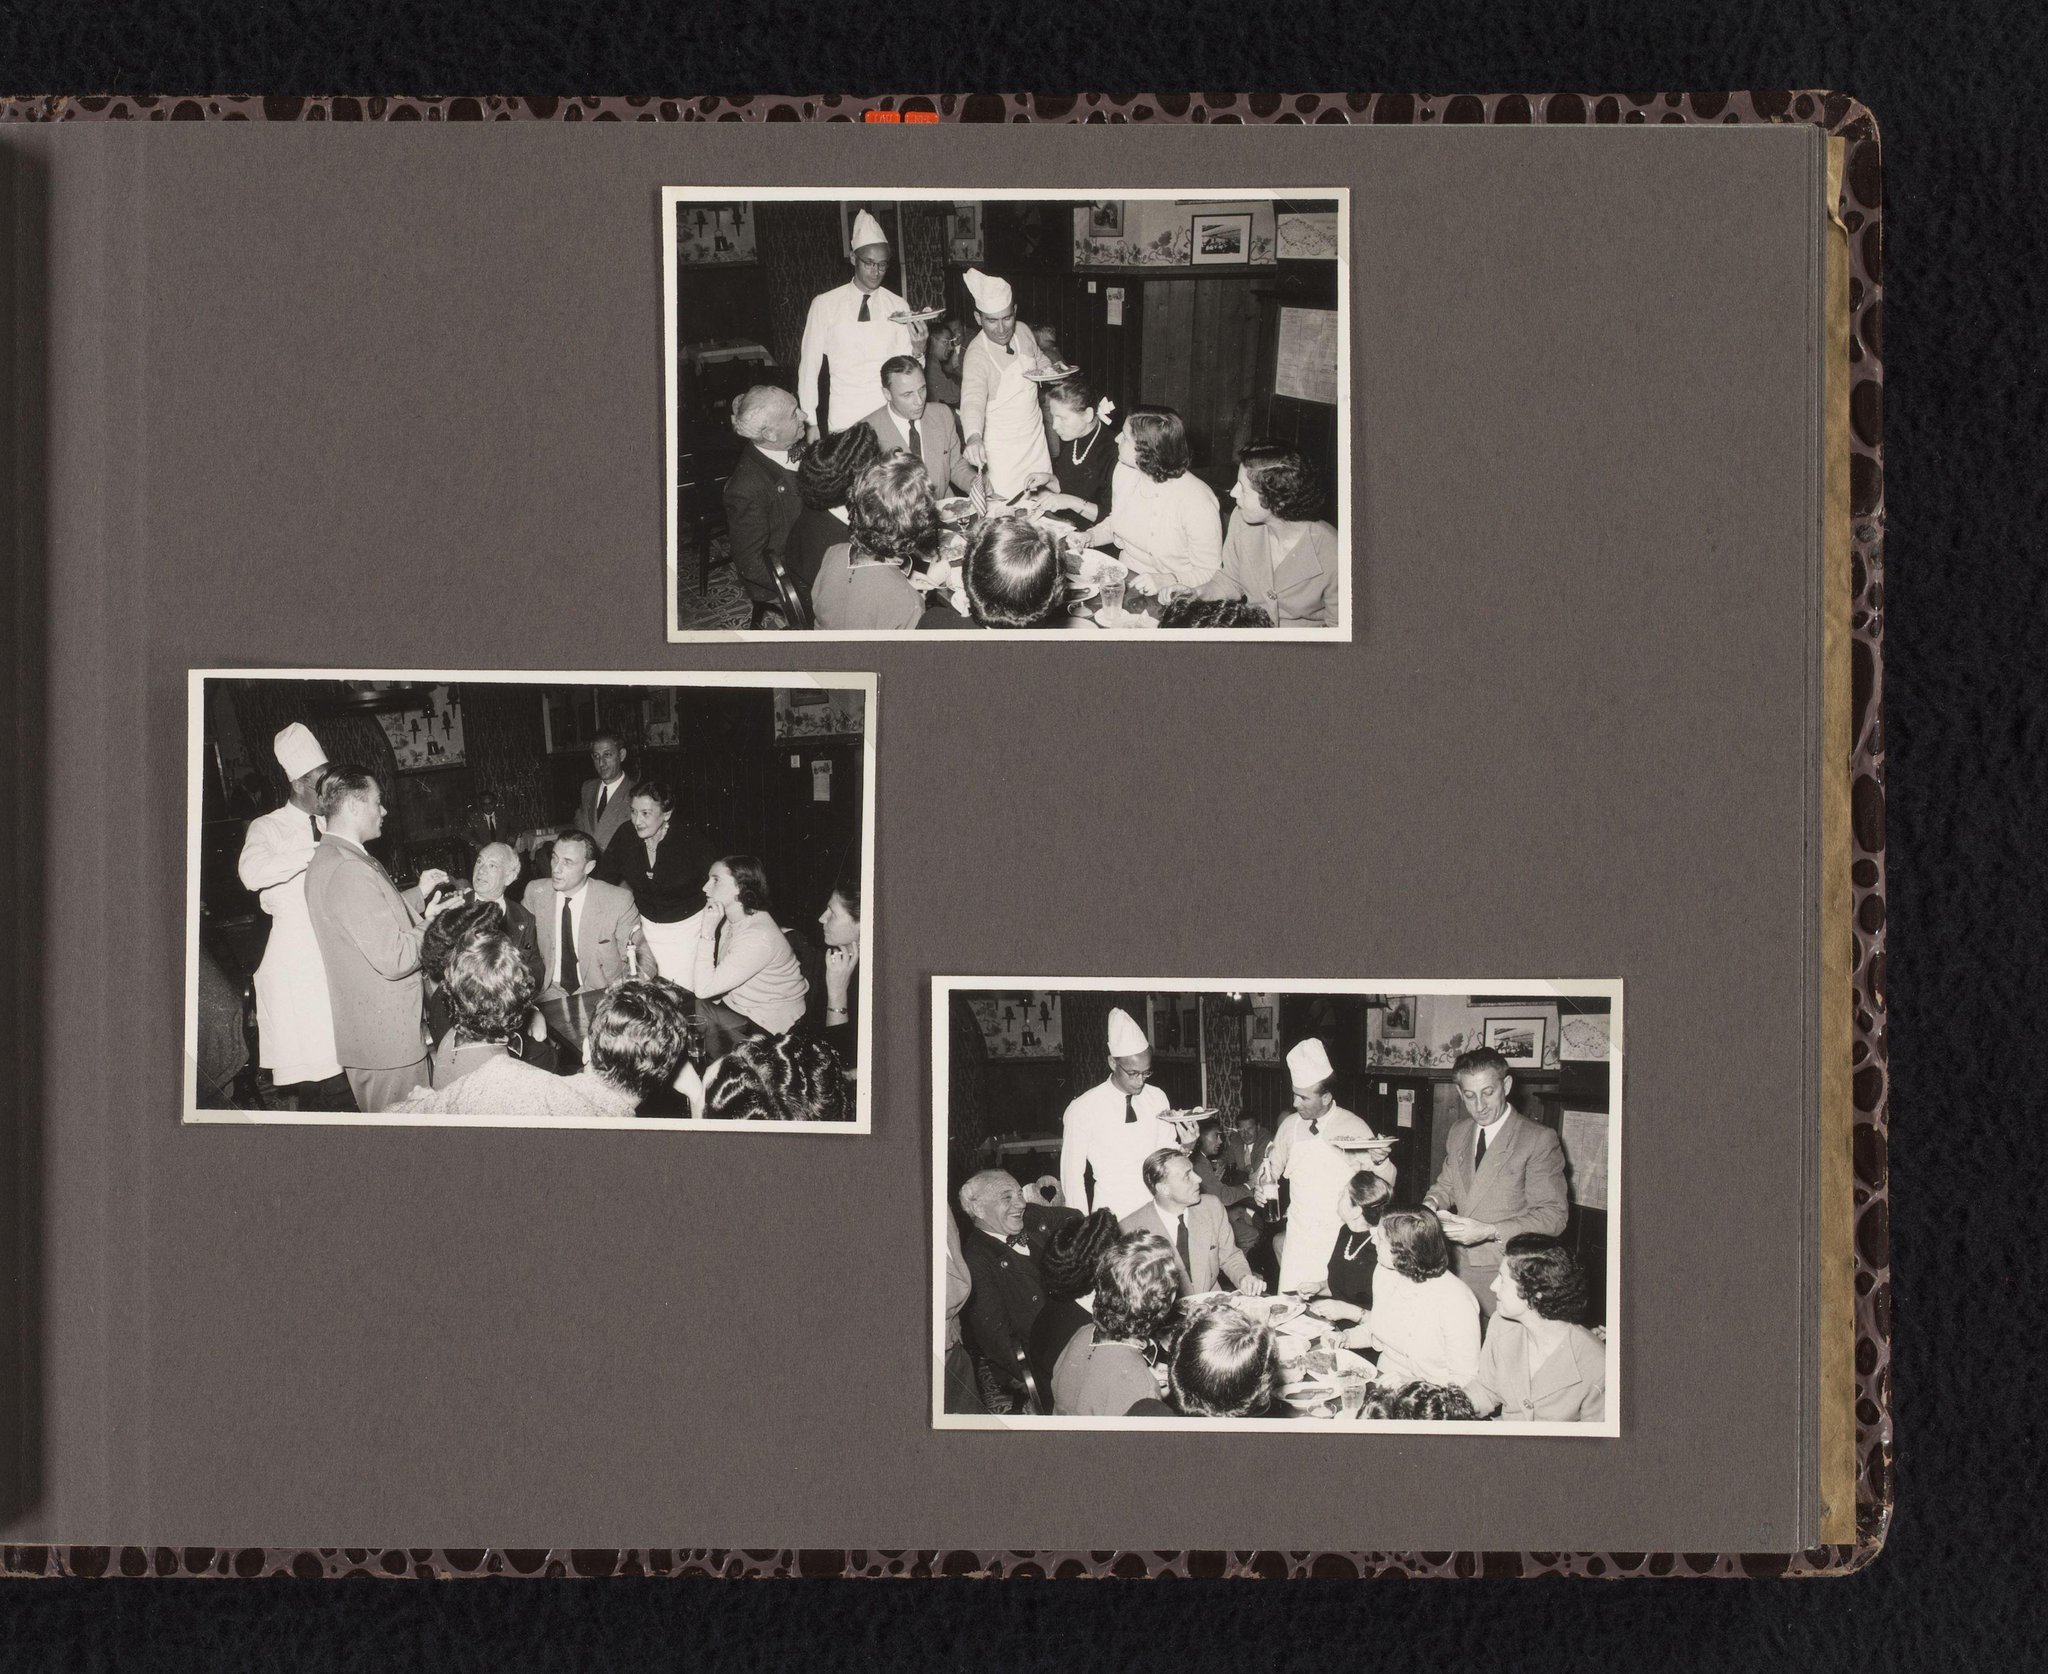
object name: album leaf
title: Isabel Wachenheimer tijdens een etentje met onbekende collega's van Isabel tijdens haar periode bij KLM, 1955, Israël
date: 1955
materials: cardboard, photographic support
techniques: gelatin silver print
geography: israel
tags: leiden, isabel wachenheimer-elon, historical persons - bb - woman, anonymous historical persons portrayed in a group, in a group-portrait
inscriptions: date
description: Blad bevat drie foto's van Isabel Wachenheimer en onbekende collega's, tijdens etentje op 1 februari 1955. Uit album half formaat, kunstlederen omslag met koordbinding.